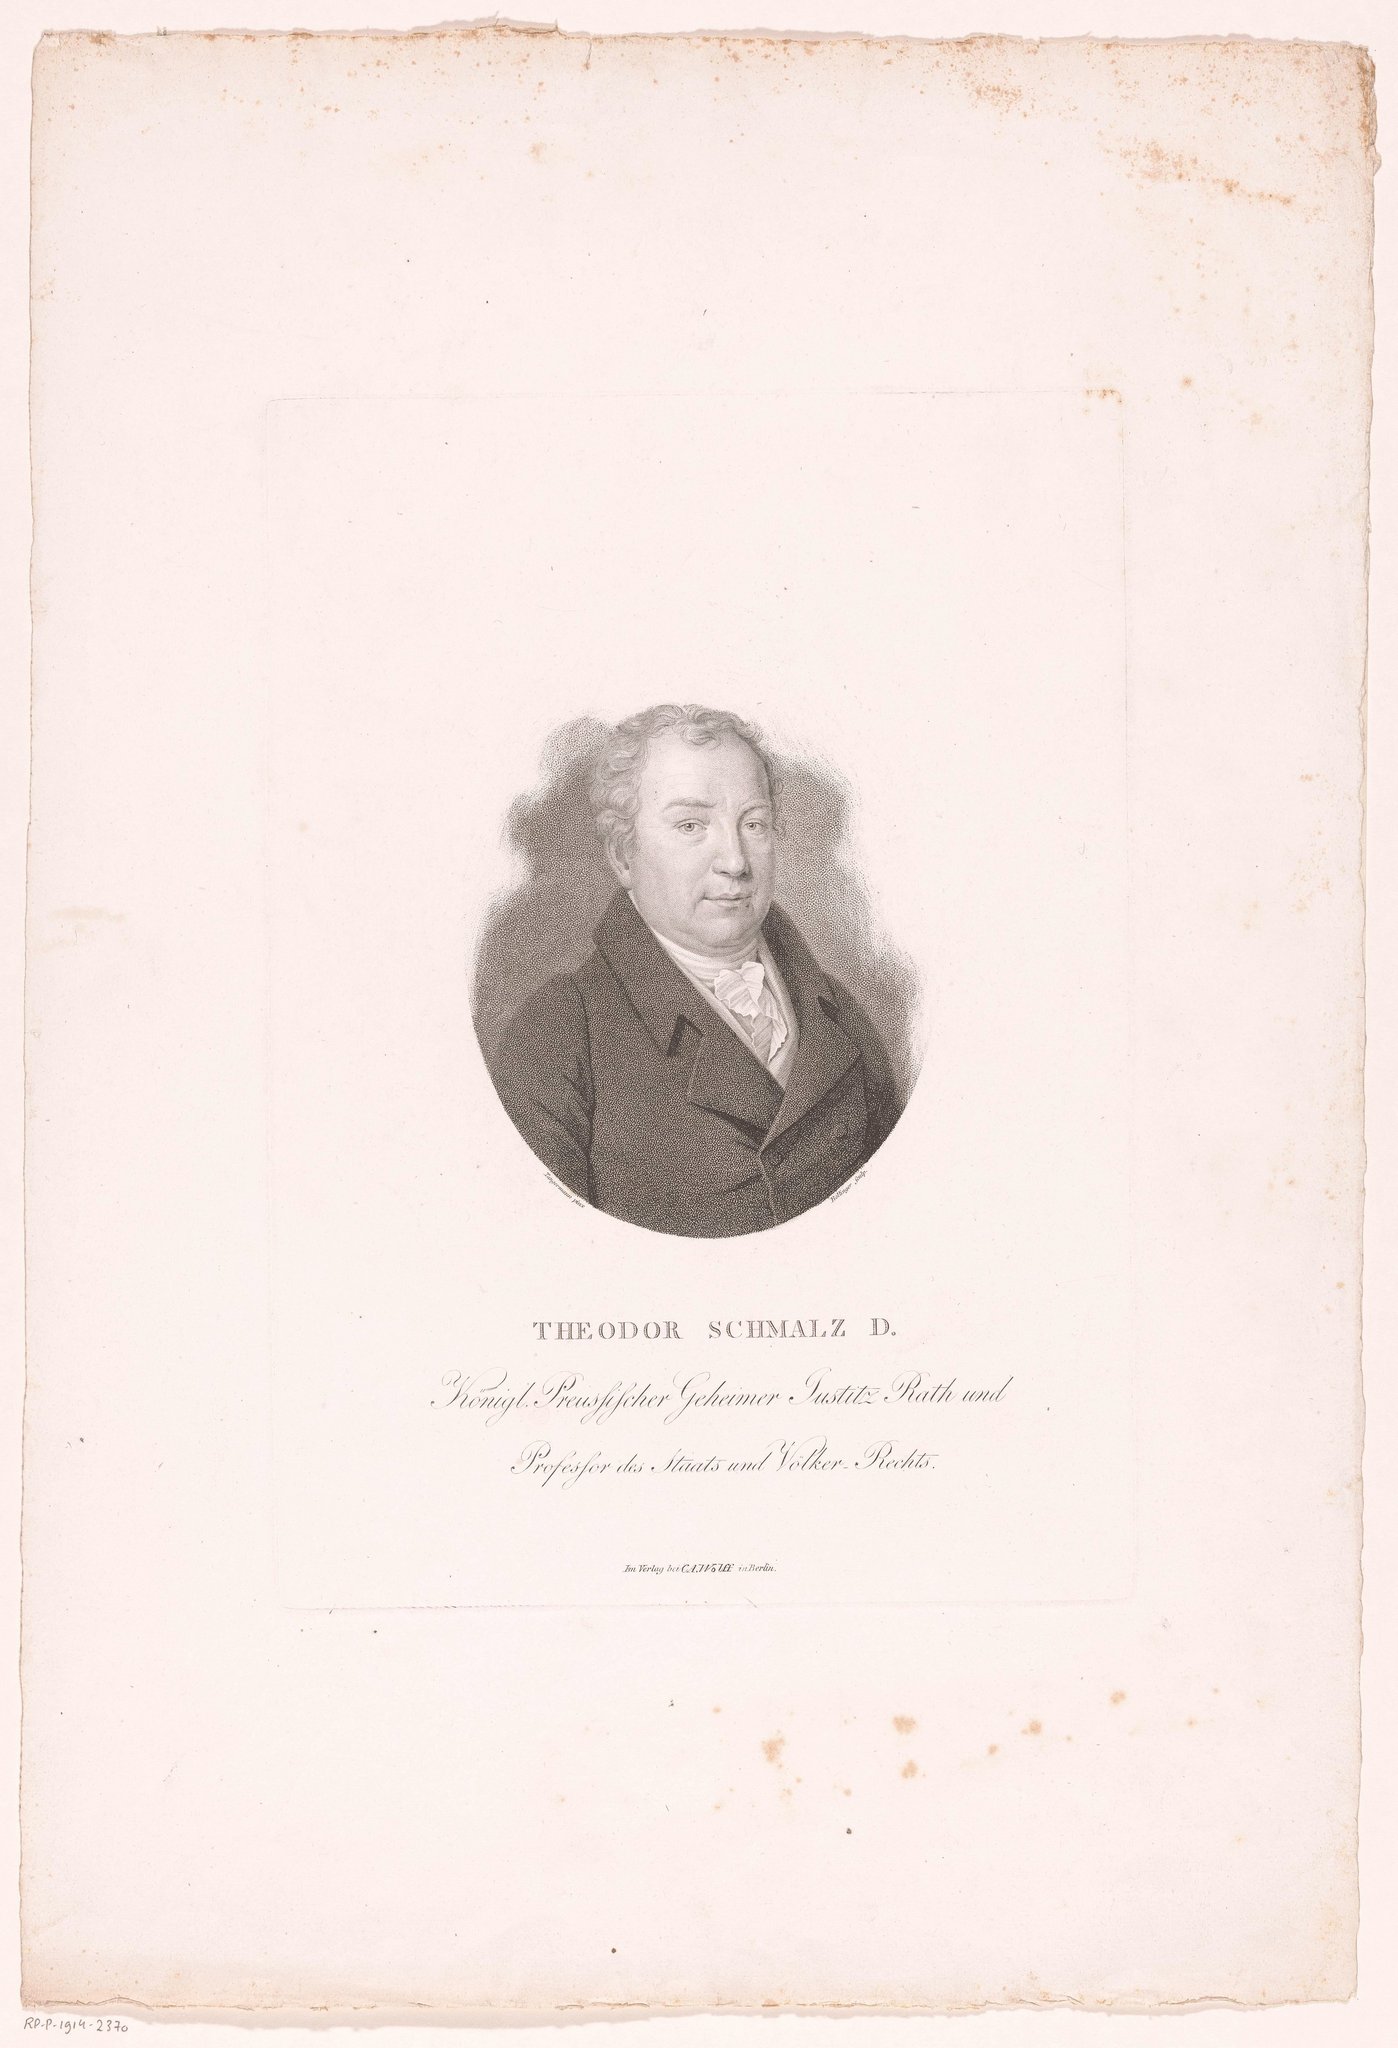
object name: print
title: Portret van Theodor Schmalz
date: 1803-1825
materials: paper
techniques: stippling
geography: berlin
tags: berlin, historical persons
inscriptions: collector's mark: Lugt 2228